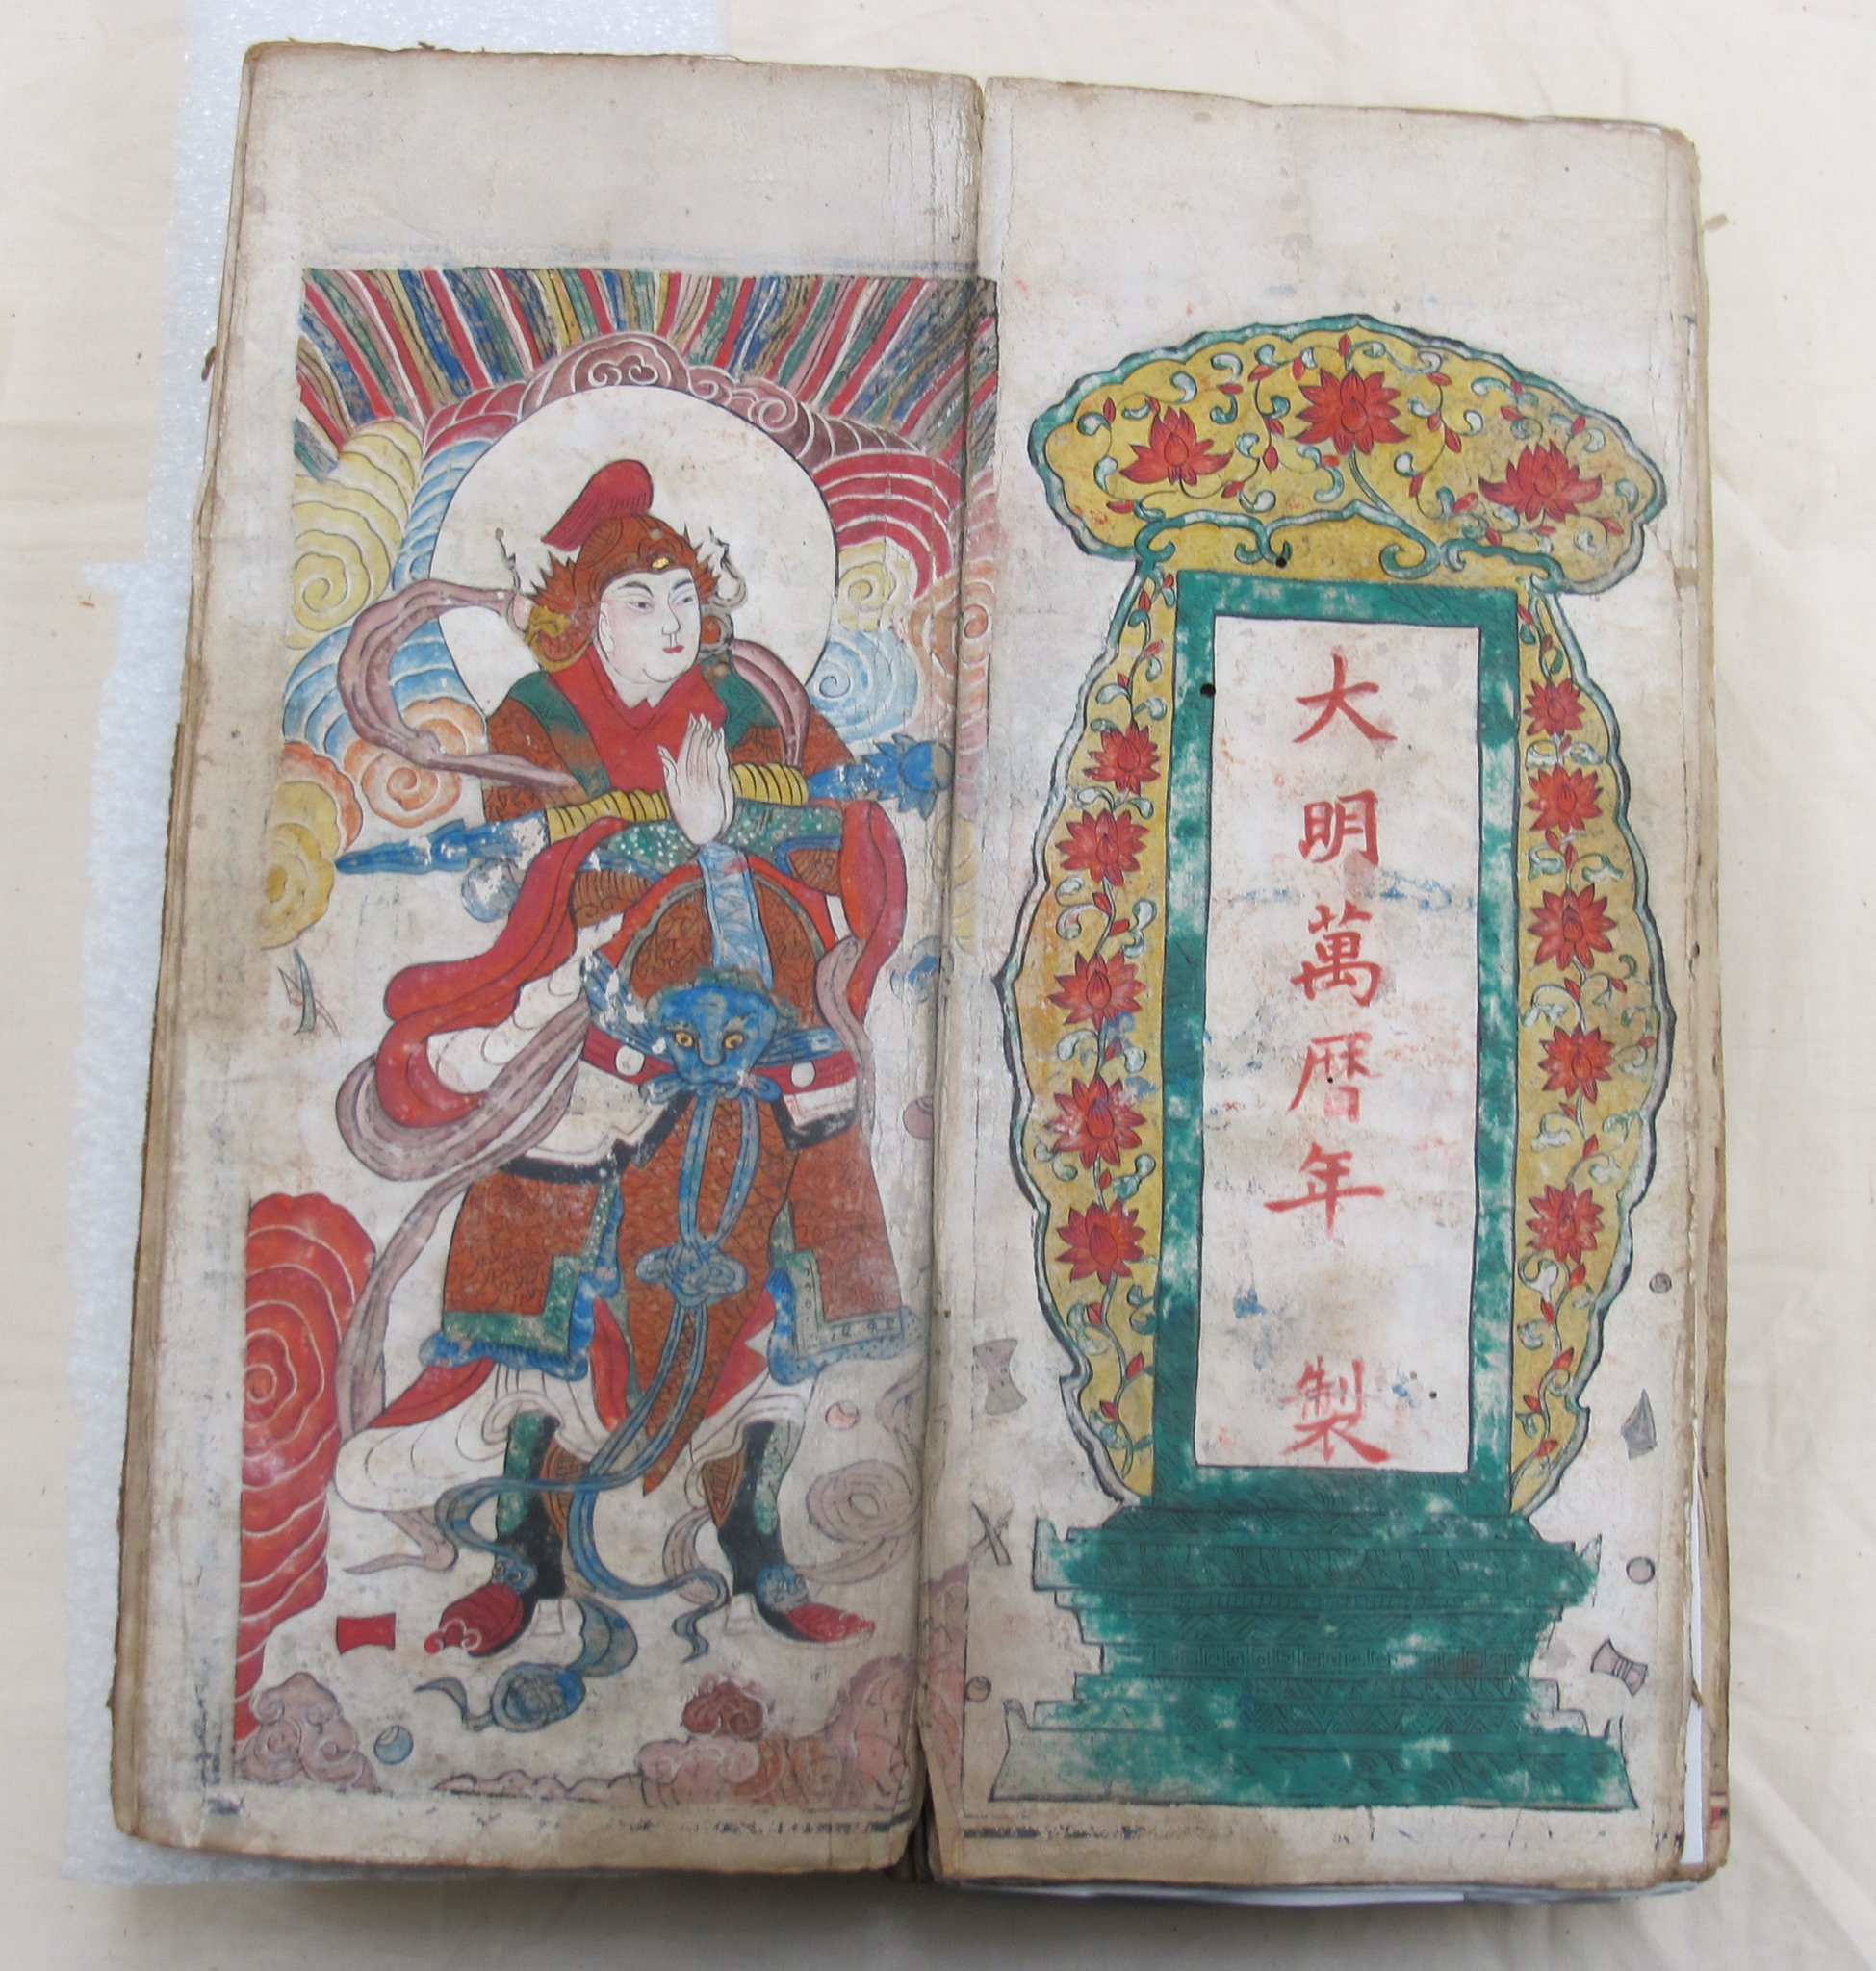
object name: illustrated book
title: The Diamond Sutra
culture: chinese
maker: unidentified artist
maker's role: artist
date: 1573-1620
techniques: painting, woodblock print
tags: buddhism